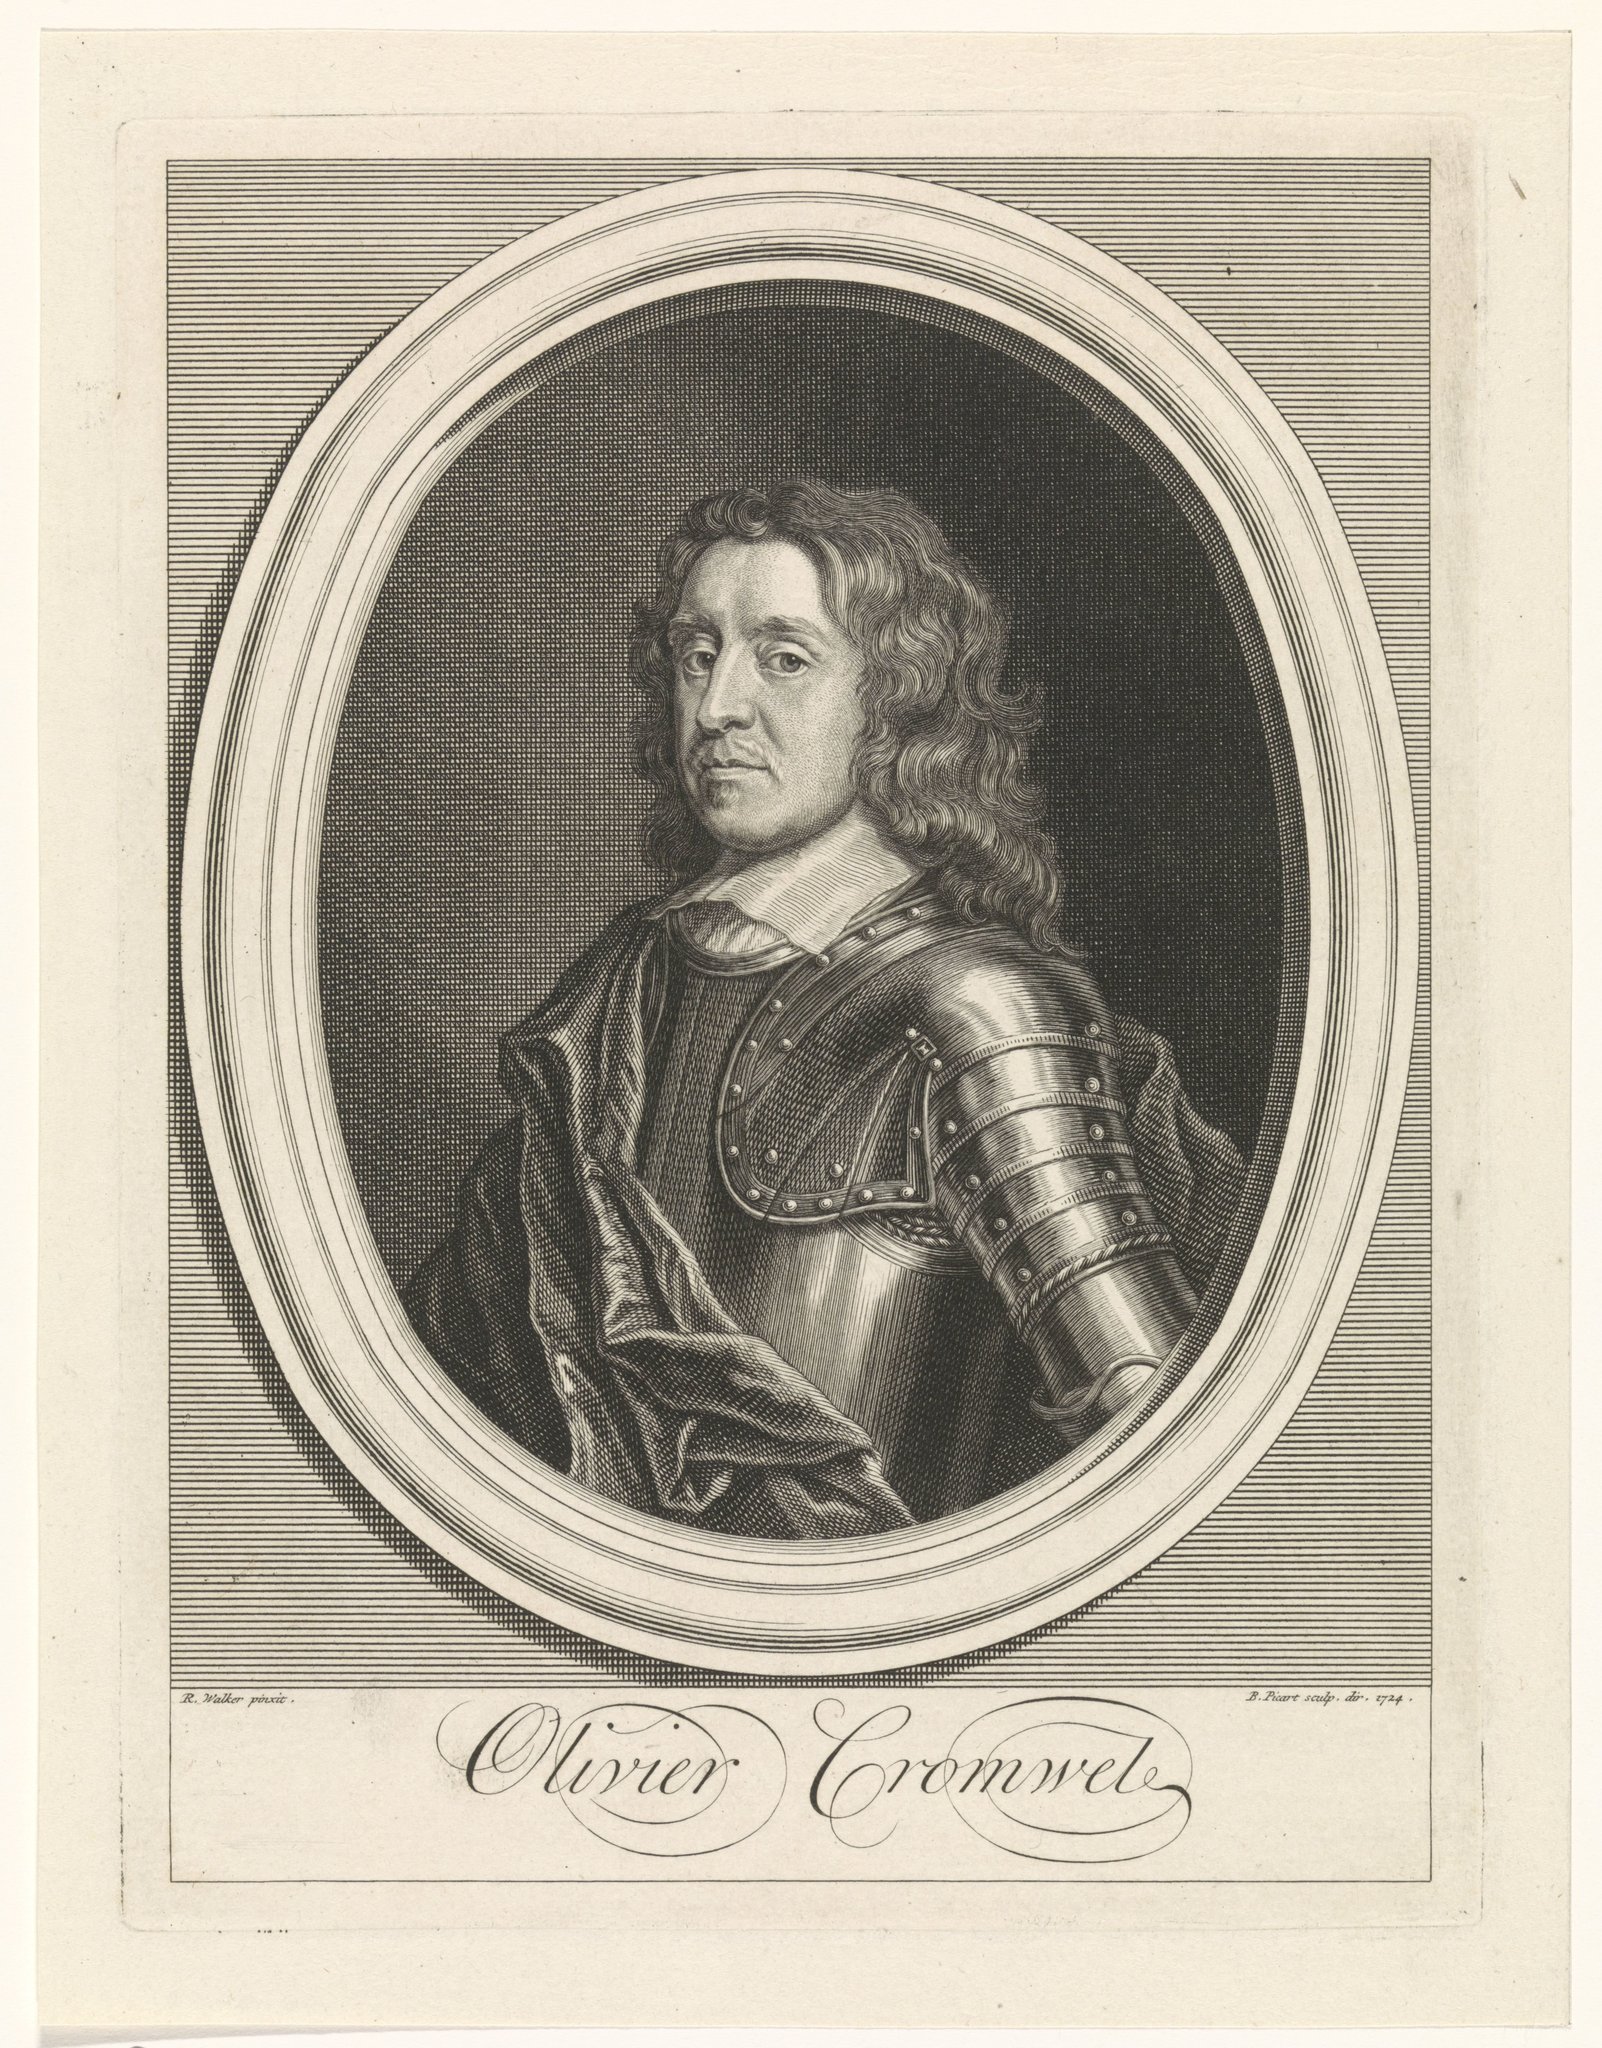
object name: print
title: Portret van Oliver Cromwell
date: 1724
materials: paper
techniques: engraving, etching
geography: amsterdam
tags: london, oliver cromwell, armour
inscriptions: collector's mark: Lugt 2228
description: Prent als illustratie gebruikt in: Burnet, Gilbert. Histoire des dernières révolutions d'Angleterre, deel I. Den Haag: Jean Neaulme, 1725.